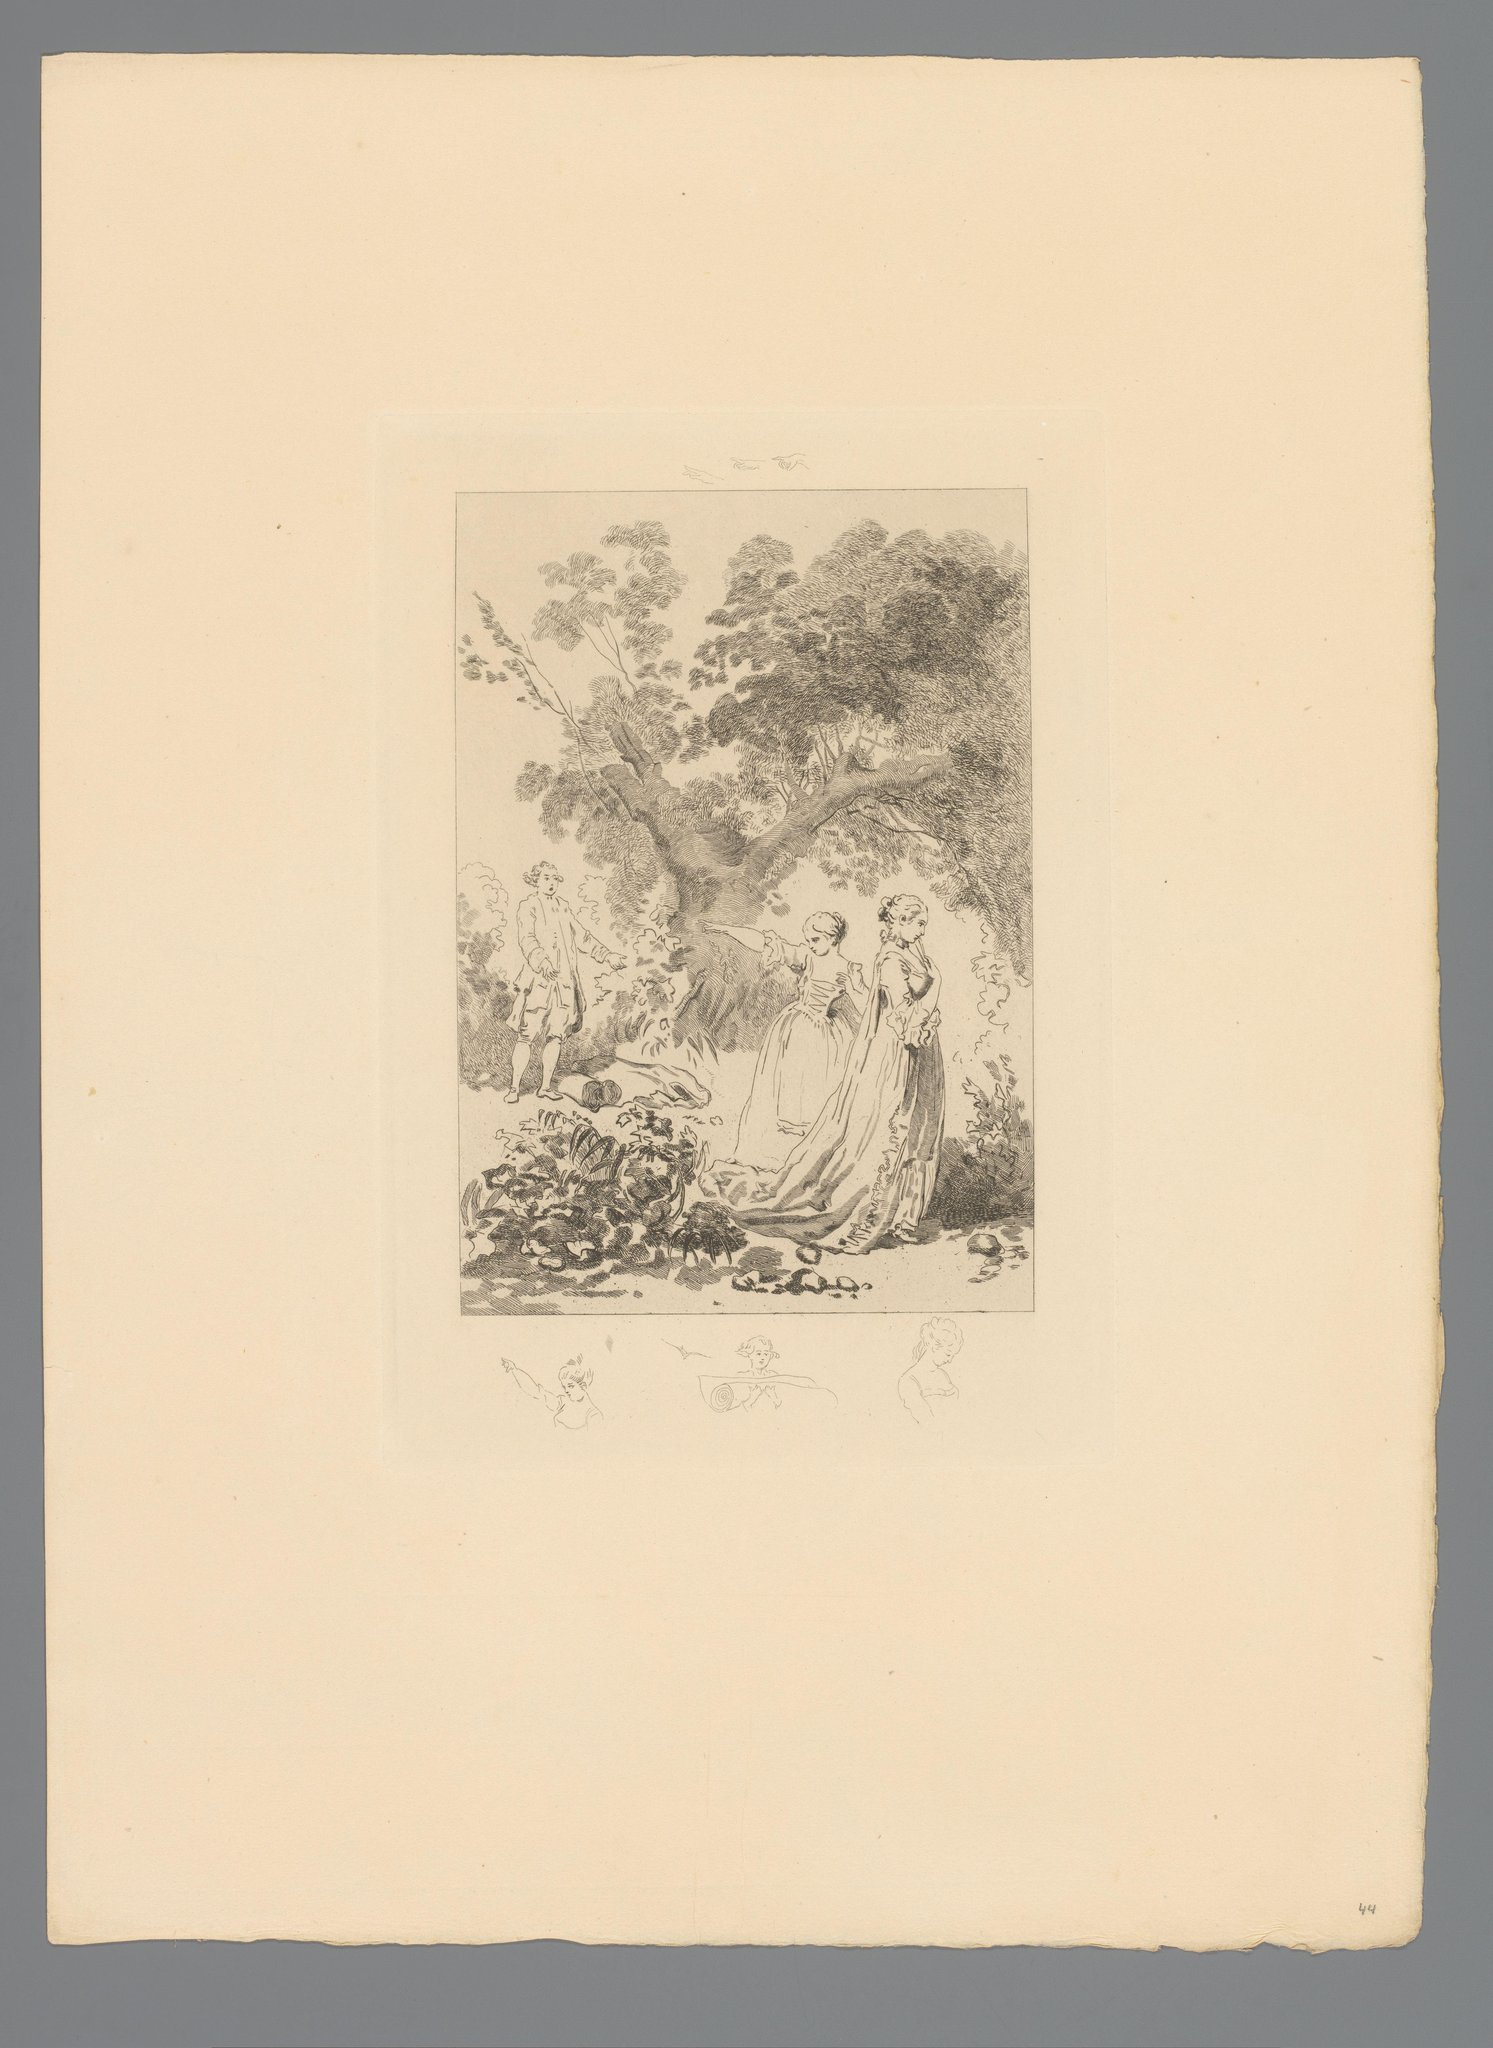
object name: reproduction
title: Figures des Contes de La Fontaine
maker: Anonymous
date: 1880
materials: paper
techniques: photoaquatint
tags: adult woman, tapestry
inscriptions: collector's mark:, collector's mark: Lugt 2228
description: Martial Potémont maakte etsen naar de tekeningen van Fragonard, die zich bevonden in een manuscript in de collectie van de verzamelaar Eugène Paillet. Rouquette bood hem aan de tekeningen zo exact mogelijk in prent te laten brengen door Martial Potémont: dit resulteerde in een serie van 57 etsen. Vervolgens werden deze gereproduceerd door middel van heliogravure. Deze omslag betreft een editie voor de letter, "Eau forte pure", de 1e staat van 3 waar men uit kon kiezen bij deze serie.